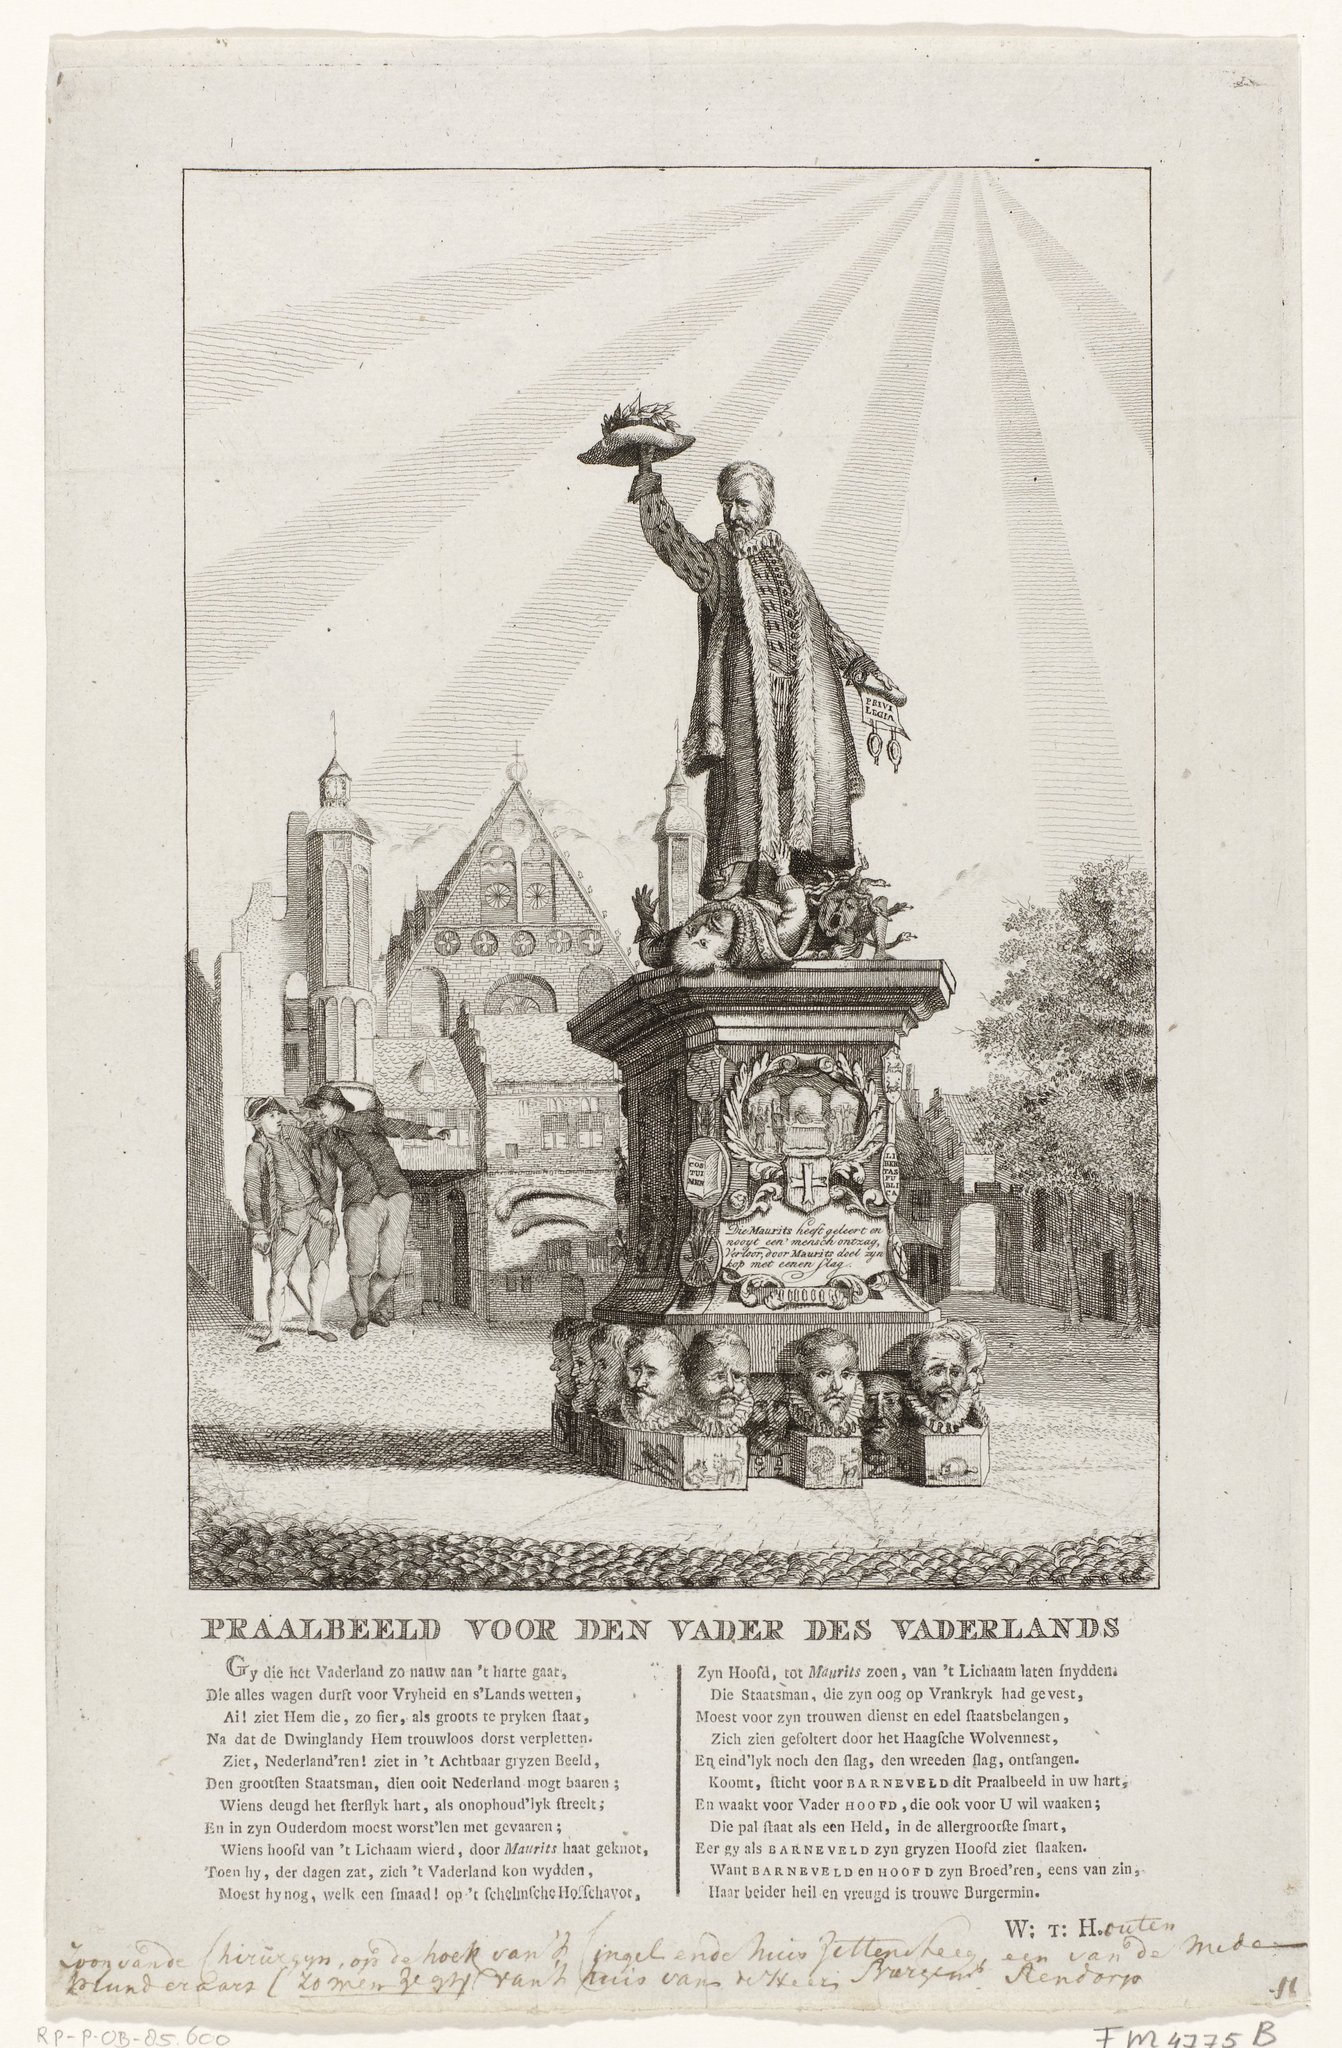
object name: print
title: Monument voor Johan van Oldenbarnevelt en Hendrik Danielsz. Hooft, 1787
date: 1787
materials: paper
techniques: engraving, etching, letterpress printing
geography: northern netherlands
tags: johan van oldenbarnevelt, amsterdam, mayor, hendrik danielsz. hooft, piece of sculpture, reproduction of a piece of sculpture, patriots (1780-1795)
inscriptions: inscription: ‘Zoon van de Chirurgyn, op de hoek van 't Cingel ende huis Jettensteeg, een van de mede-plunderaars (zo men zegt) van 't huis van de Heer Burgems. Rendorp.’ Lugt Deze informatie betreft W. ten Houten, de schrijver van het vers., collector's mark: 2228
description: Allegorisch standbeeld voor Johan van Oldenbarnevelt, gestorven 13 mei 1619. De landsadvocaat met vrijheidshoed en privilege in de hand, staande in triomf op prins Maurits en de personificatie van de Afgunst. Op het voetstuk een vers van vier regels, het beeld rustend op de hoofden van de 24 rechters die Van Oldenbarnevelt ter dood veroordeeld hebben met de hierbij corresponderende dieren. Op het grote plein van het Binnenhof. Op de achtergrond bespreken een boer en een heer, beiden patriotten, het standbeeld. Onder de voorstelling een vers in twee kolommen waarin Van Oldenbarnevelt vergeleken wordt met de Amsterdamse burgemeester Hendrik Danielsz. Hooft in zijn rol als verdediger van de belangen van de burgerij in 1787.